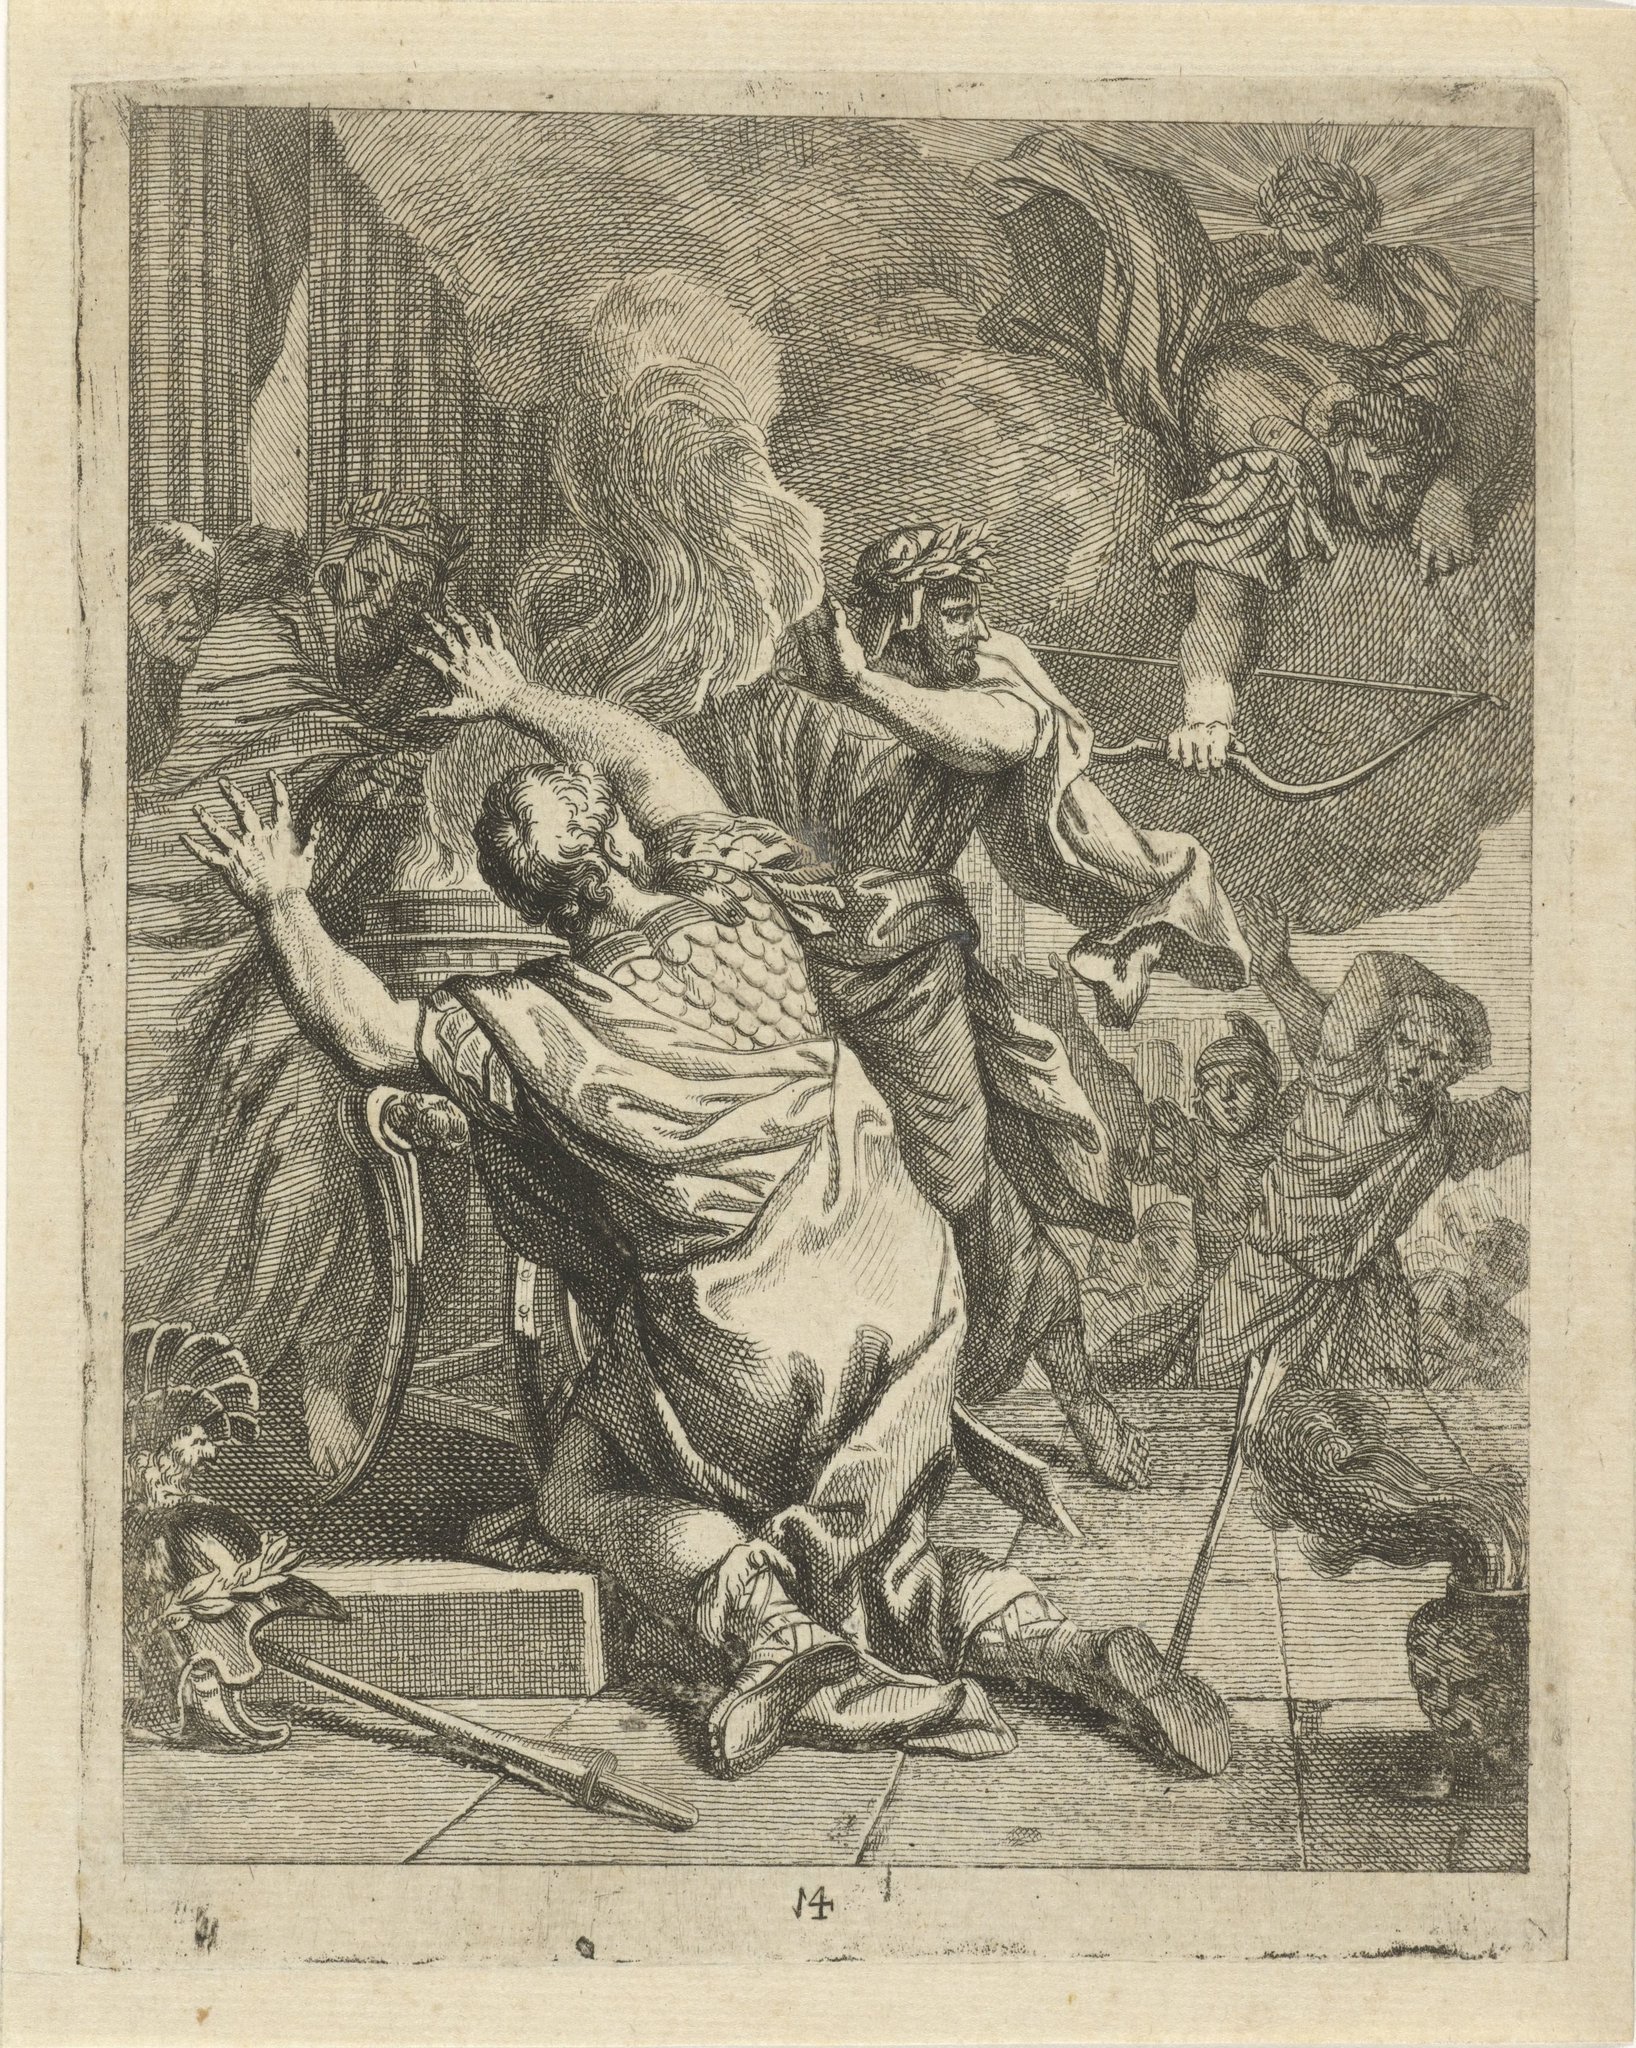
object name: print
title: Scènes uit het leven van Achilles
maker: j. alexander janssens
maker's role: print maker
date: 1700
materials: paper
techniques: engraving, etching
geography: southern netherlands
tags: death of achilles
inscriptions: collector's mark: Lugt 2228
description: Achilles wordt door een pijl in zijn enige zwakke plek, zijn hiel, getroffen, terwijl hij bij een altaar een offer brengt. Diverse omstanders rond het altaar. Rechtsboven leidt Apollo de pijl van Paris naar de juiste plek. Midden onder: 14. Veertiende prent uit een serie van veertien met scènes uit het leven van Achilles.